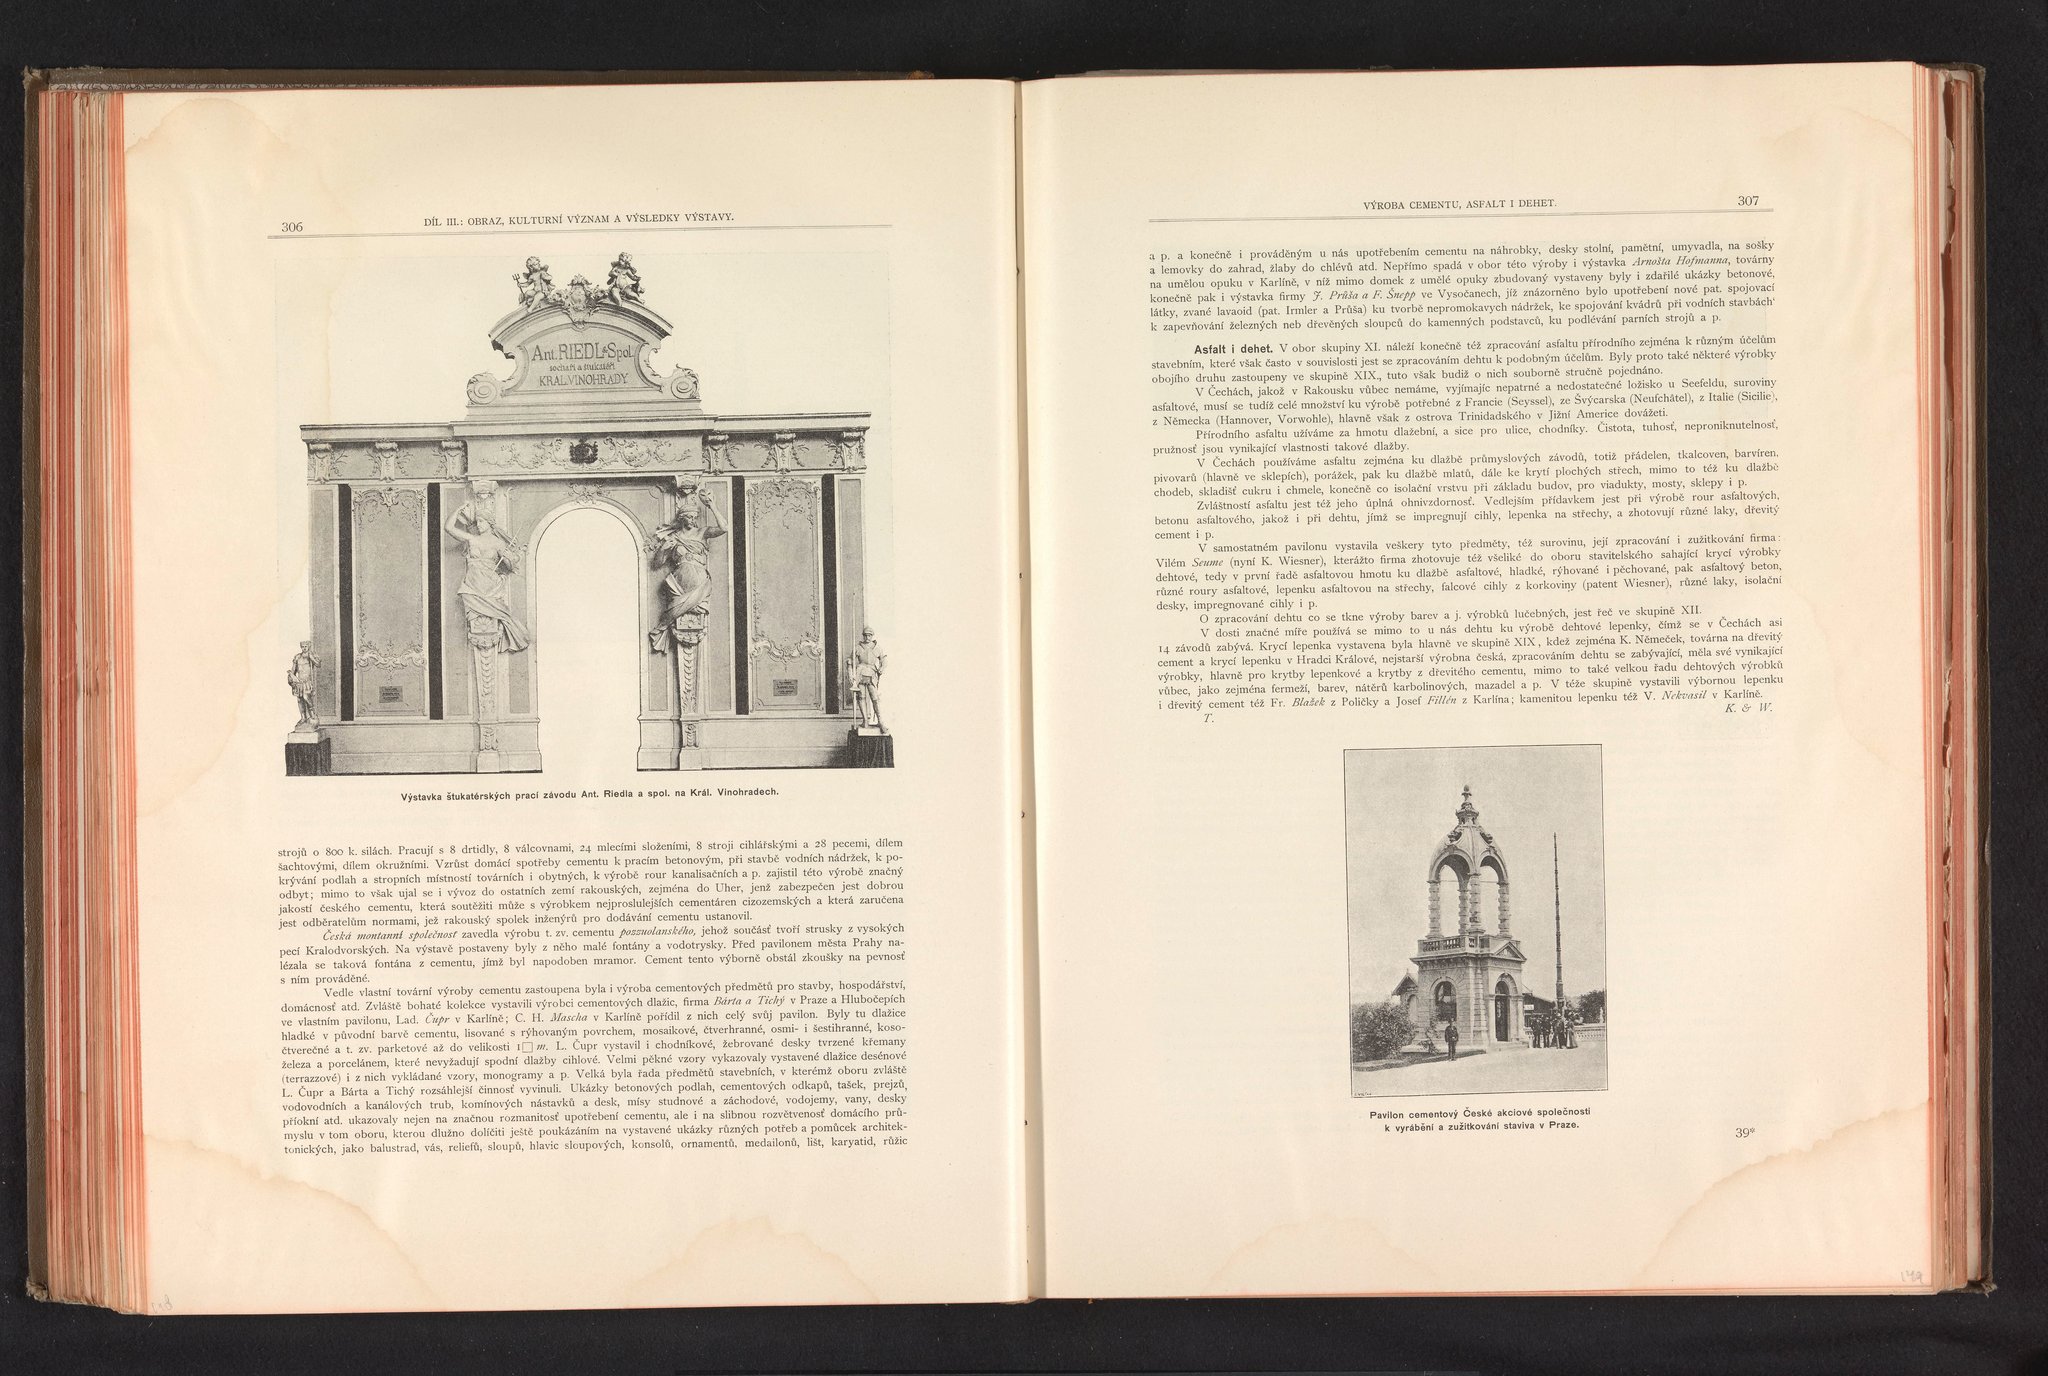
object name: page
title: Výstavka stukatérských praci závodu Ant. Riedla a spol. na Král. Vinohradech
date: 1890-1895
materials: paper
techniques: autotype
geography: prague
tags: stuccoeing, exhibition ~ art